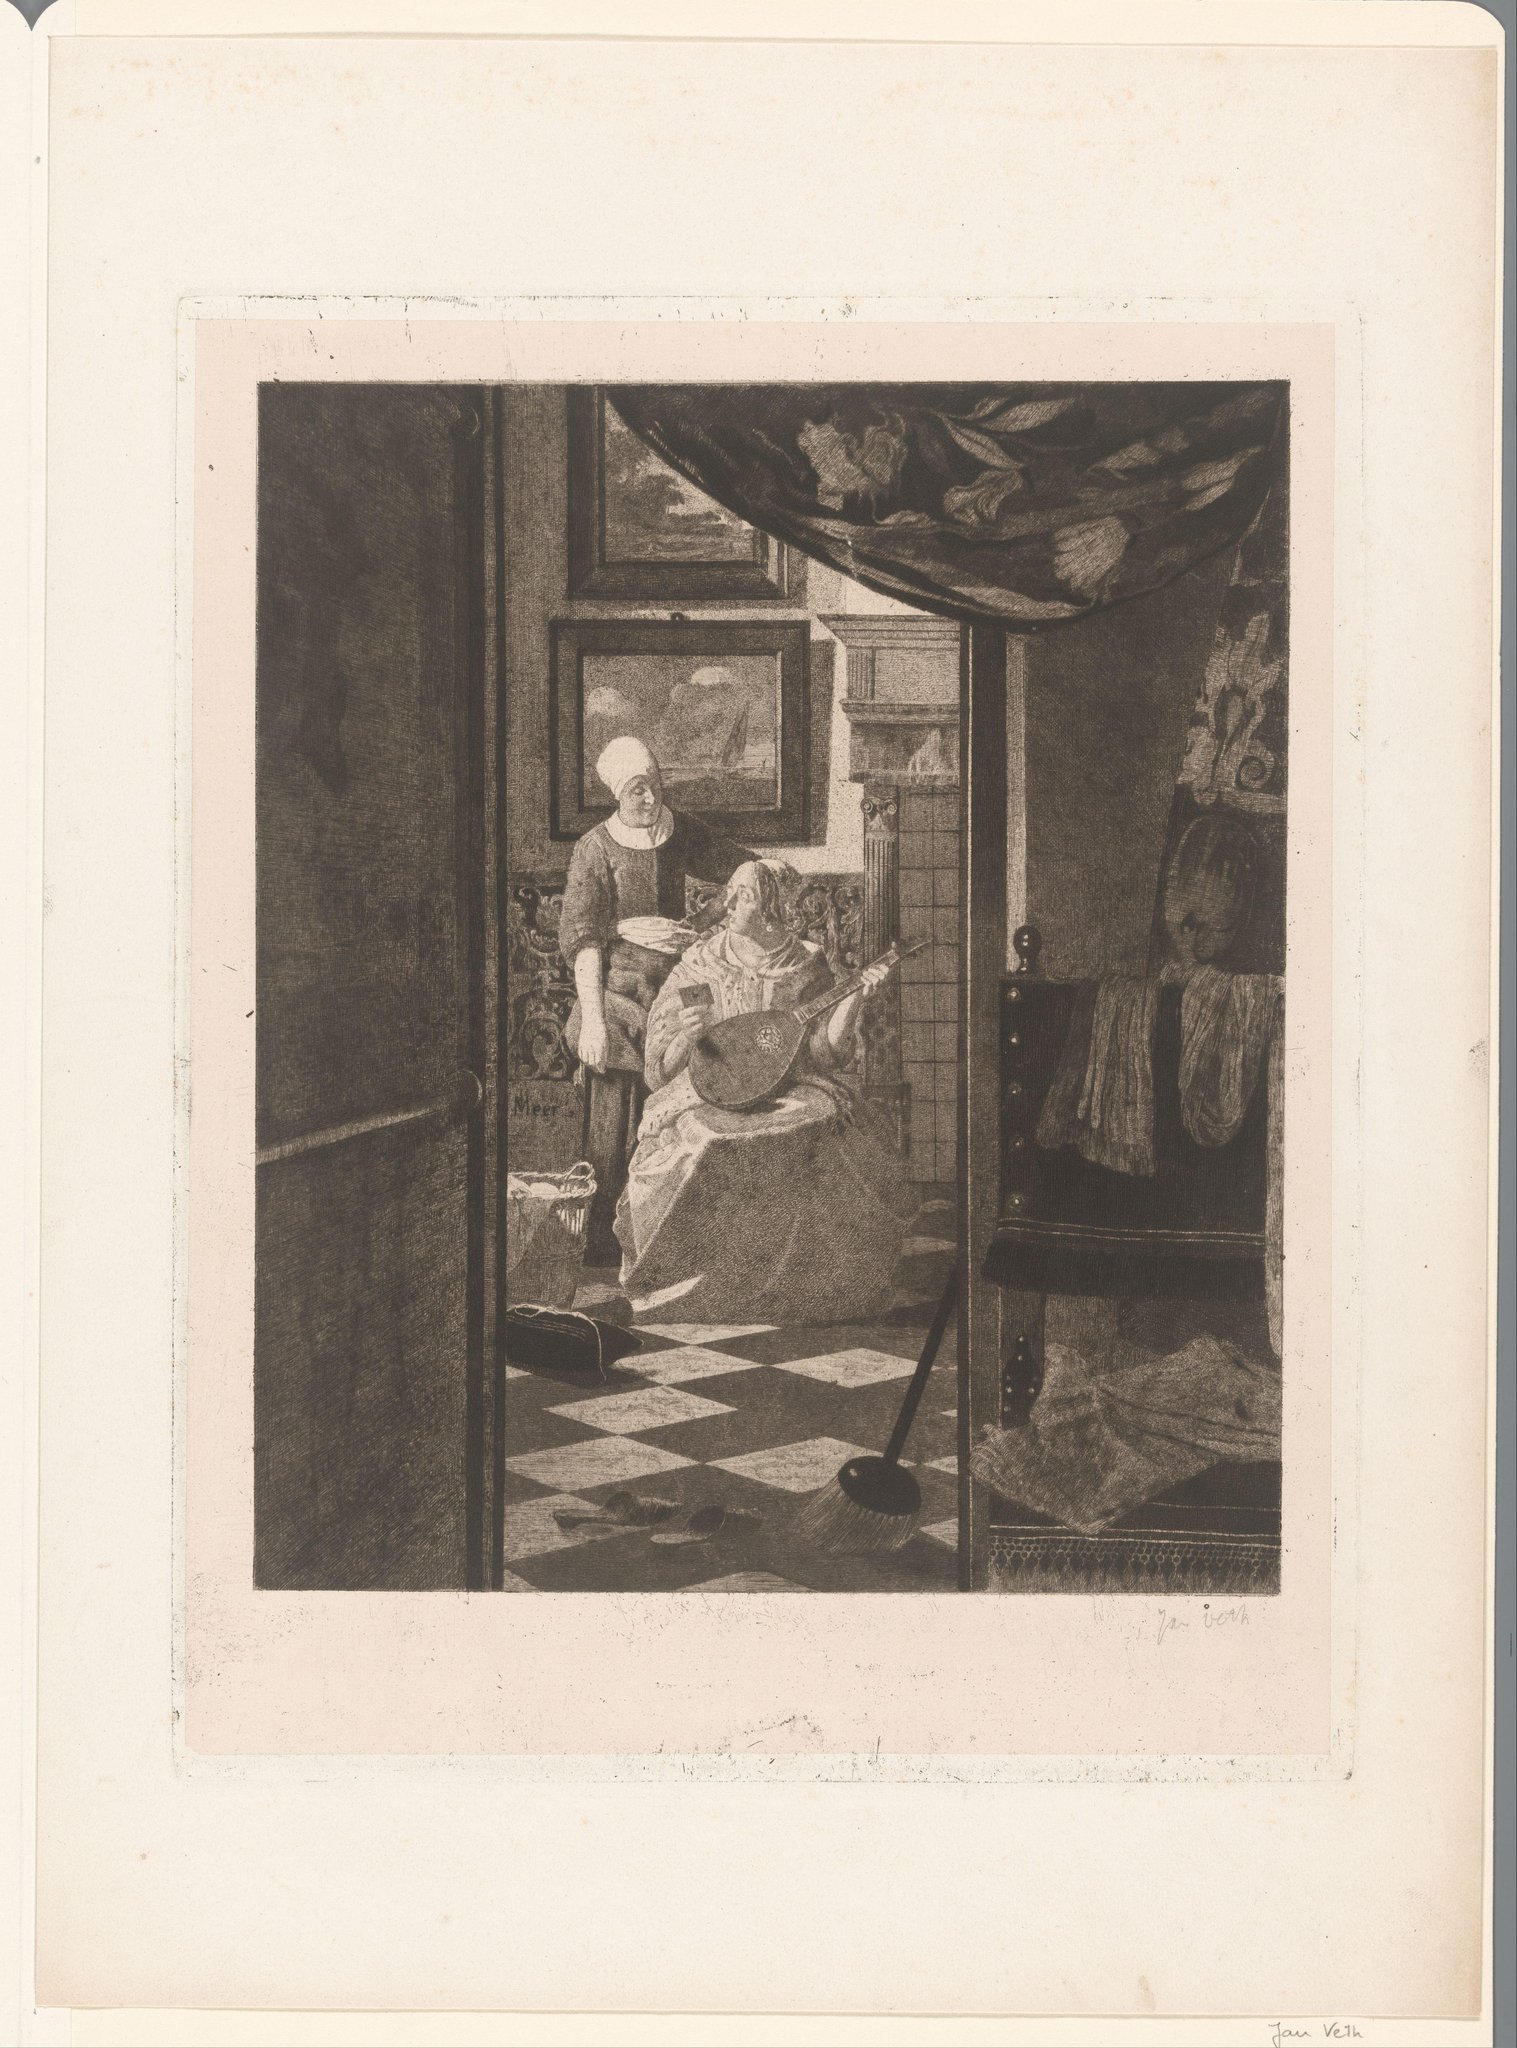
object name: print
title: De liefdesbrief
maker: jan veth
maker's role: designer, draughtsman, painter, print maker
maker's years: 1864-1925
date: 1893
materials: paper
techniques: etching, intaglio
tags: lute, and special forms of lute, e.g.: theorbo, letter, envelope, maid ~ house personnel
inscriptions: collector's mark: Lugt 2228